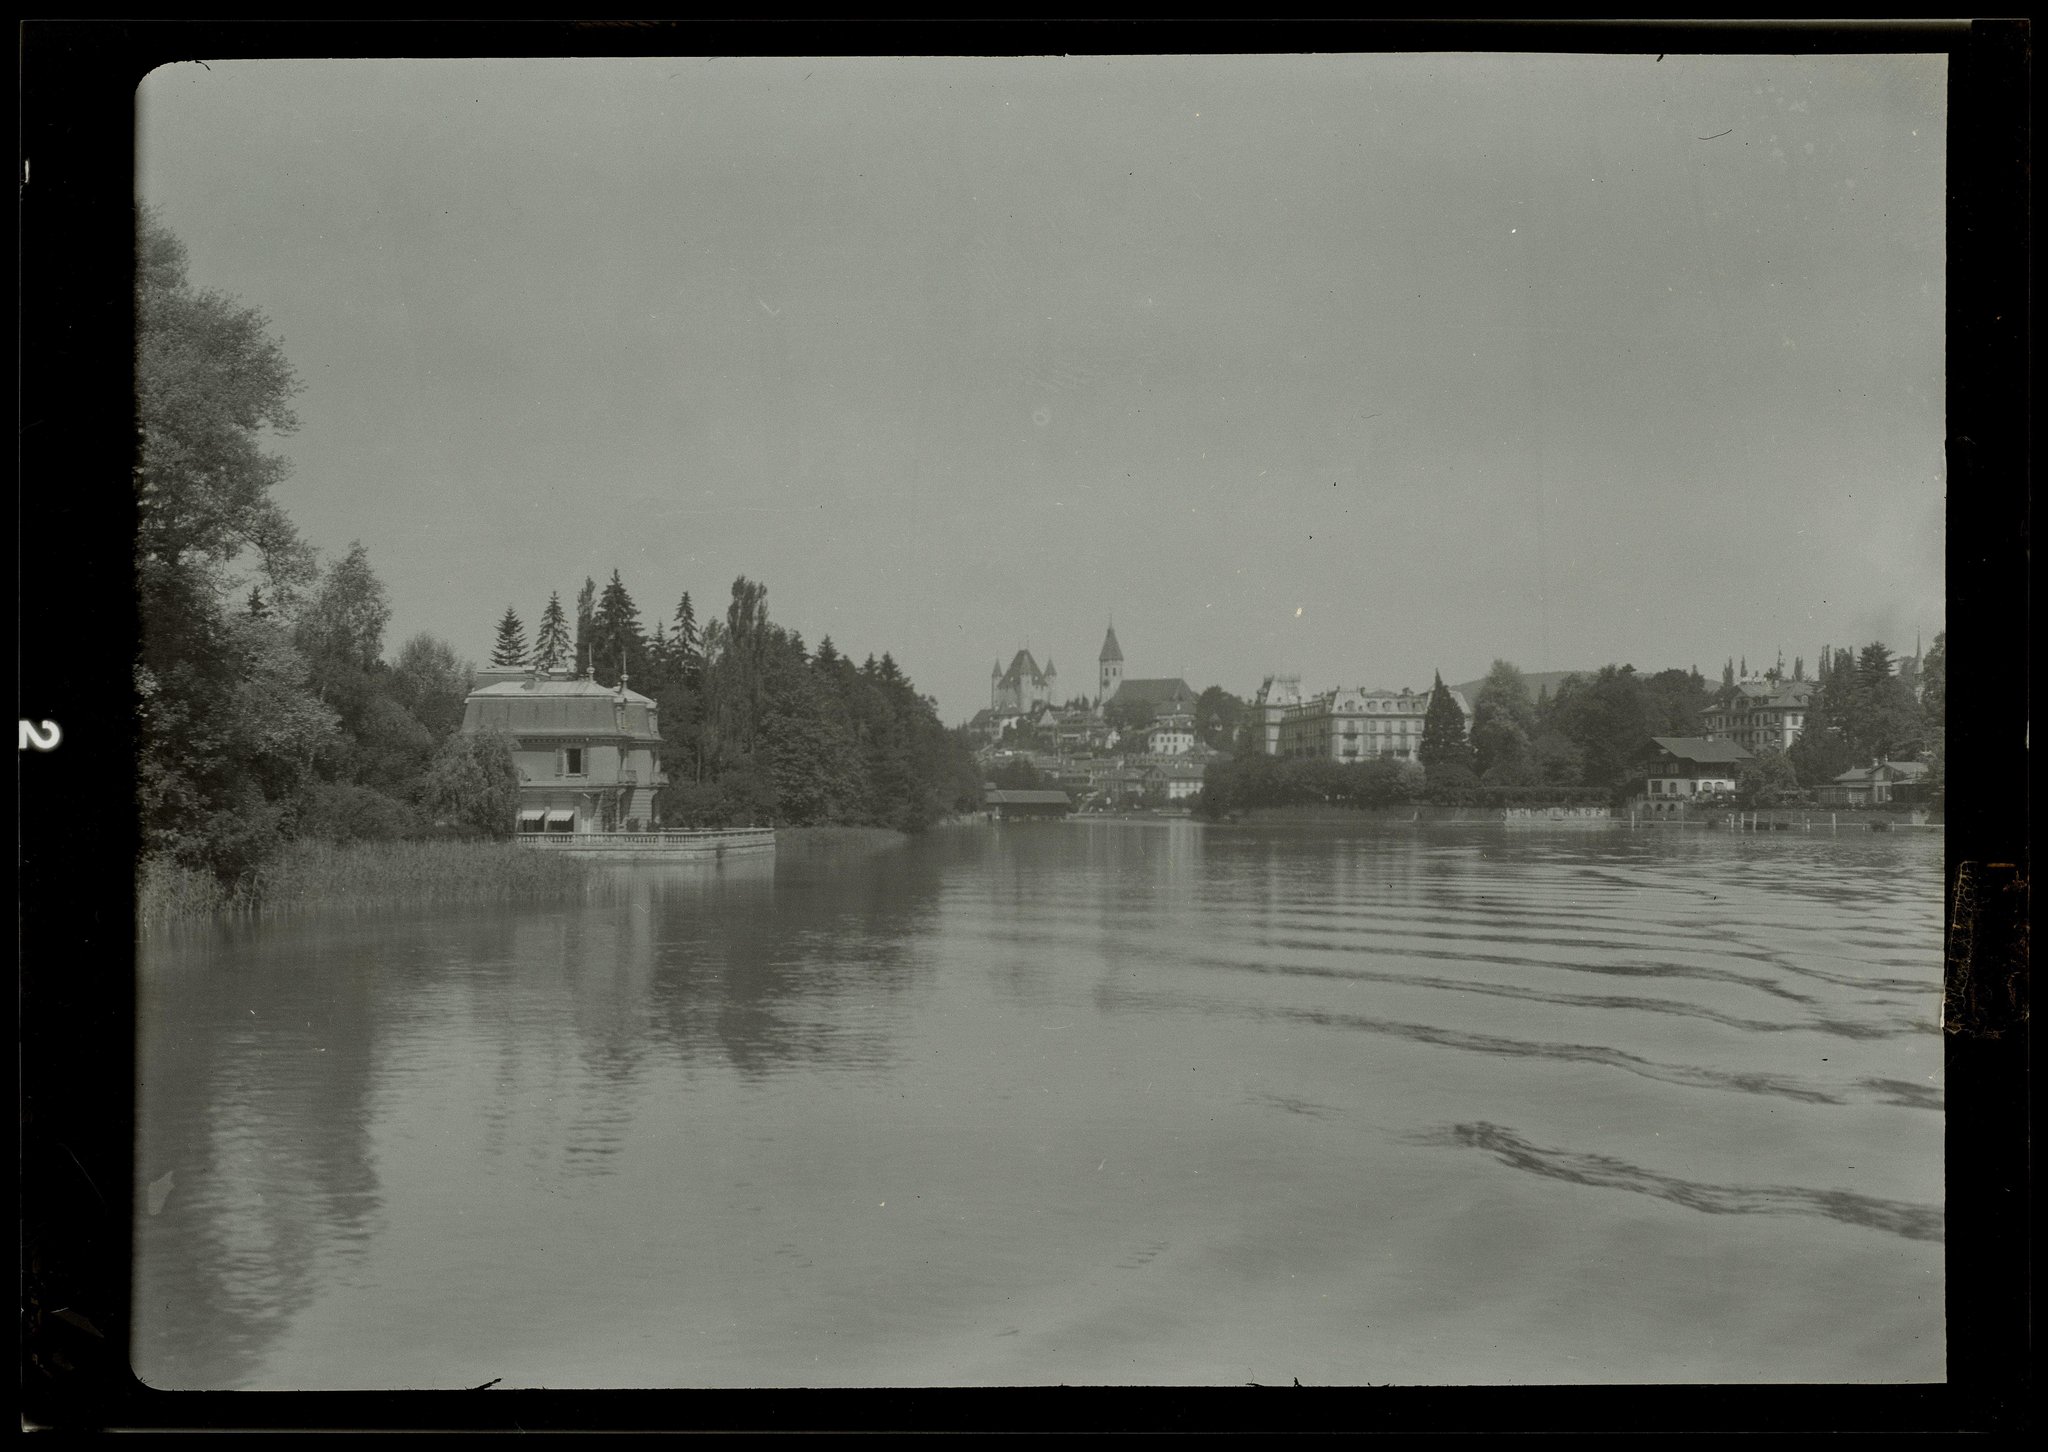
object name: negative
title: Filmnegatief met opname van Basel, Thun, Kandersteg of Gemmi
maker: Anonymous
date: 1921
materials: film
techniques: gelatin silver negative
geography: switzerland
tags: switzerland